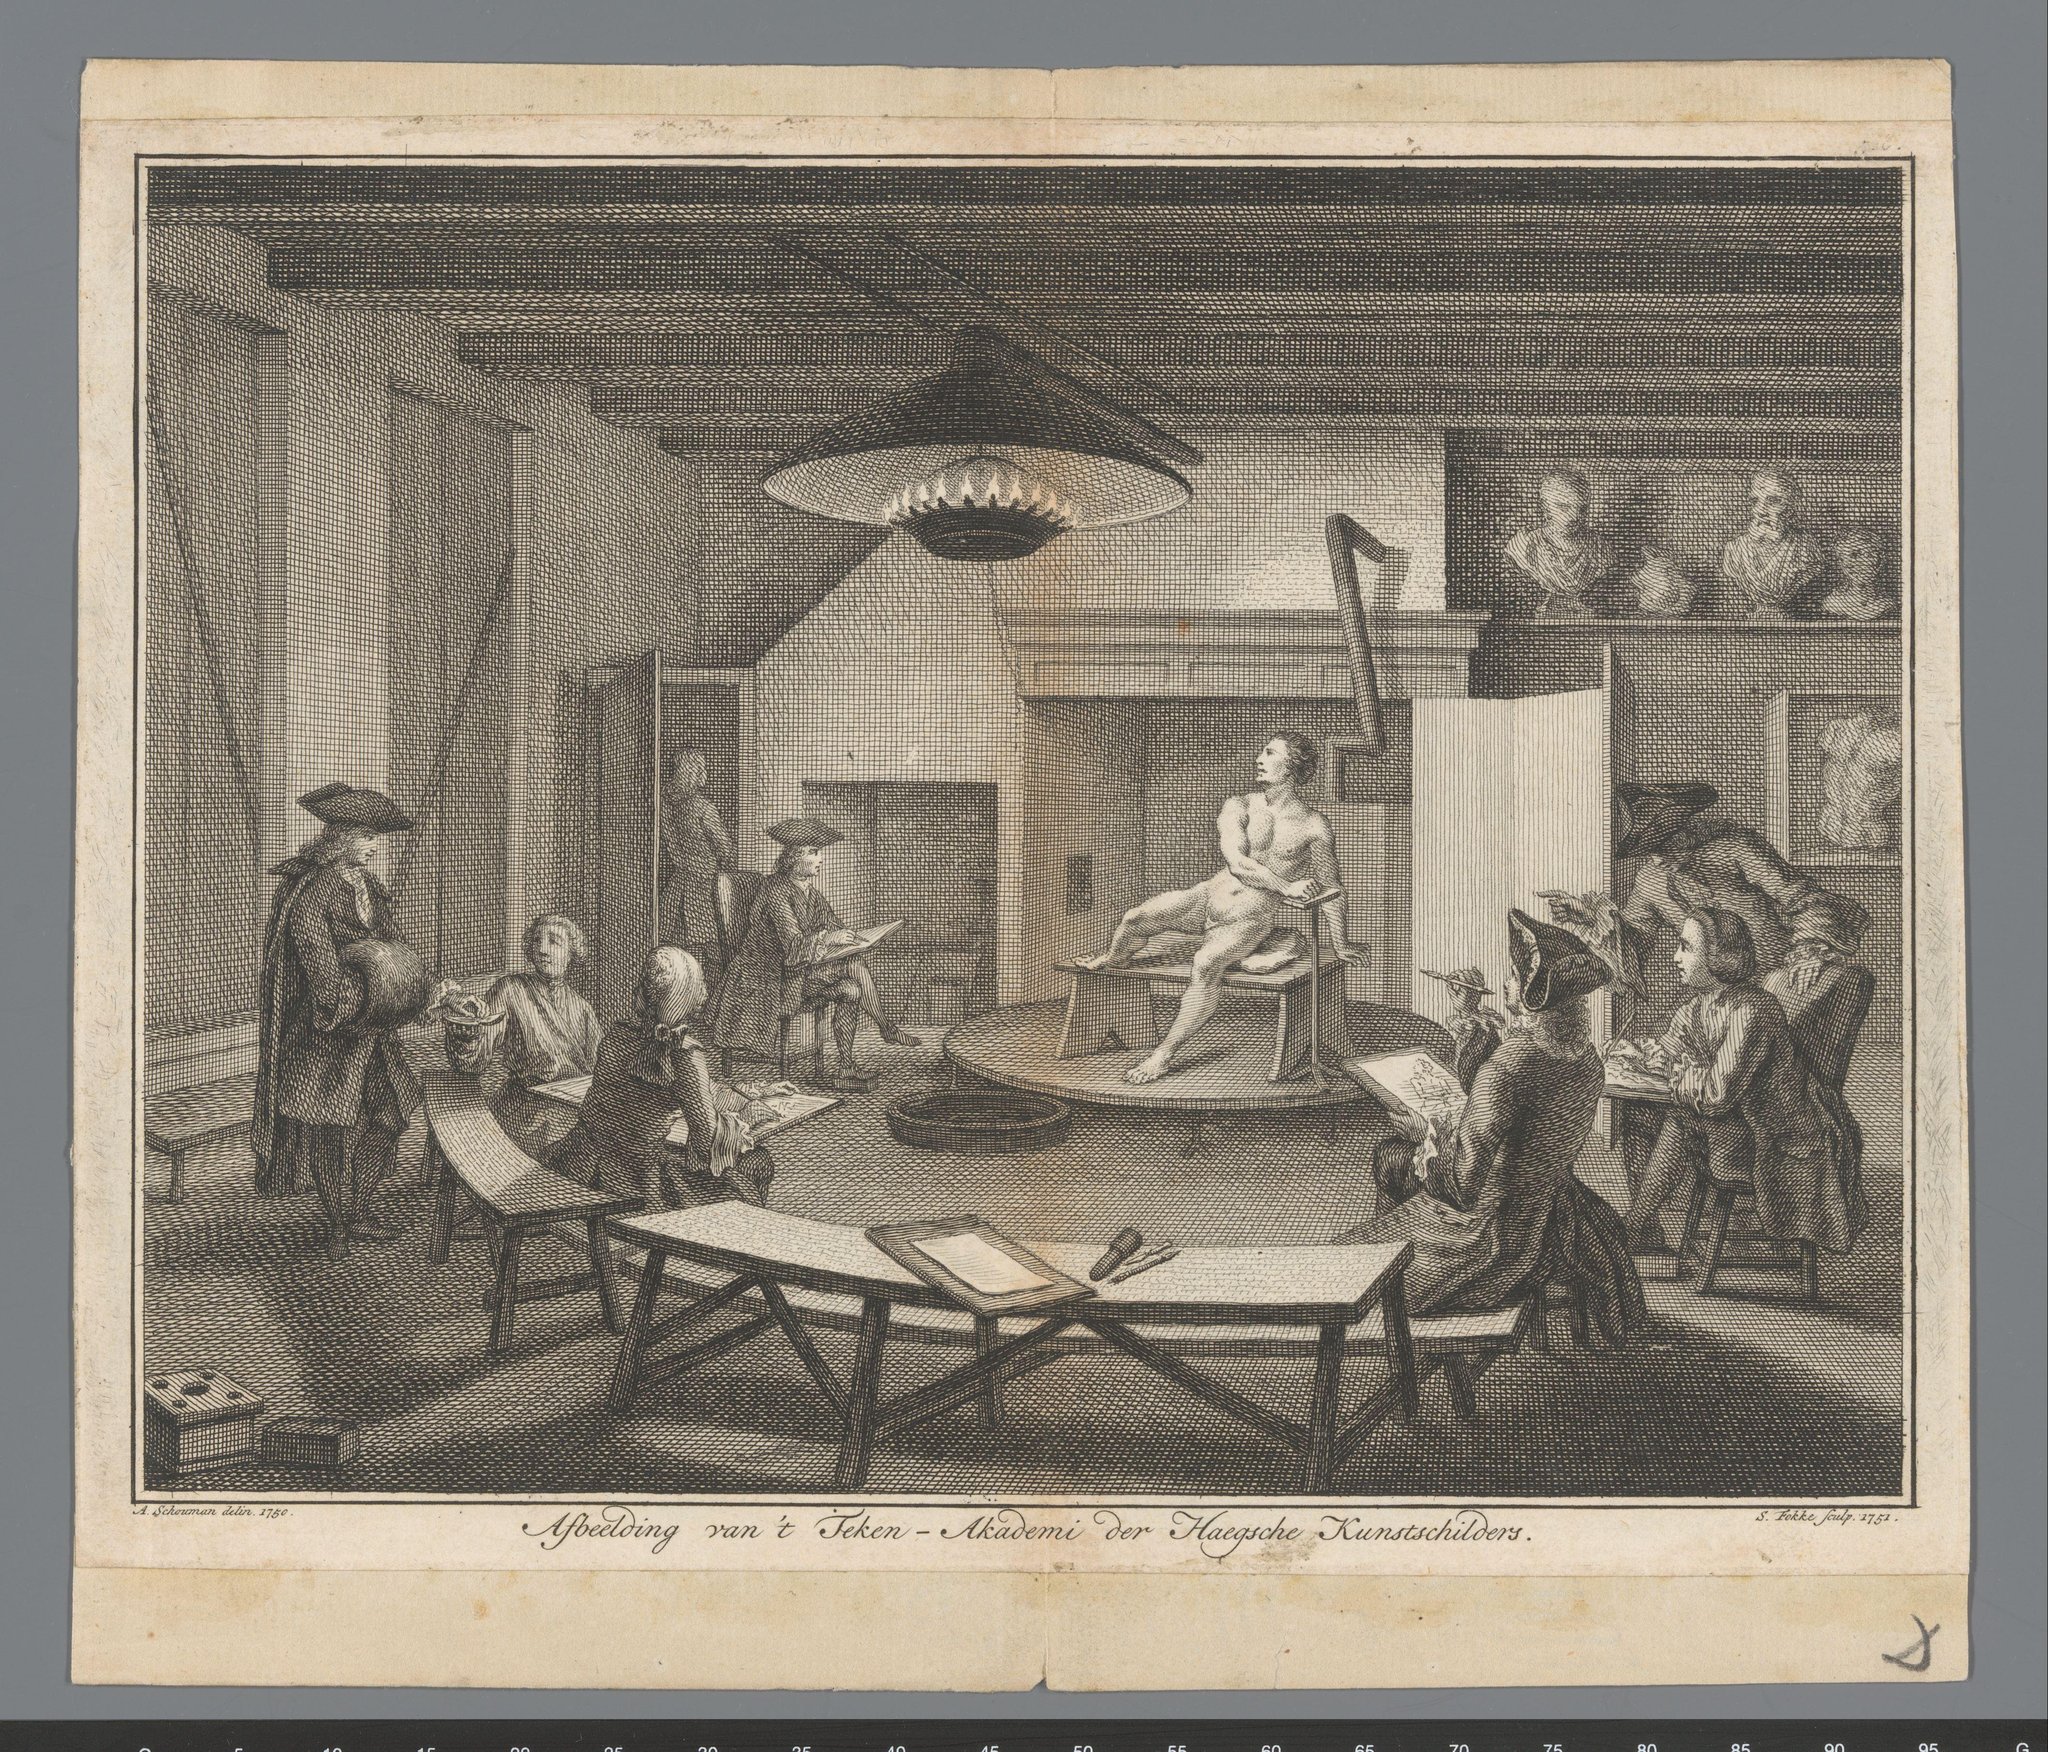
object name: print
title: Tekenacademie van de Haagse kunstschilders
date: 1751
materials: paper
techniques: etching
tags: drawing-lesson, artist (in general) working from nude model, the hague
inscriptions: collector's mark: Lugt 2228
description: De prent gebruikt voor: Gool, Johan van. De nieuwe schouburg der Nederlantsche kunstschilders en schilderessen. Den Haag: s.n., 1751, dl. 2, p. 518.